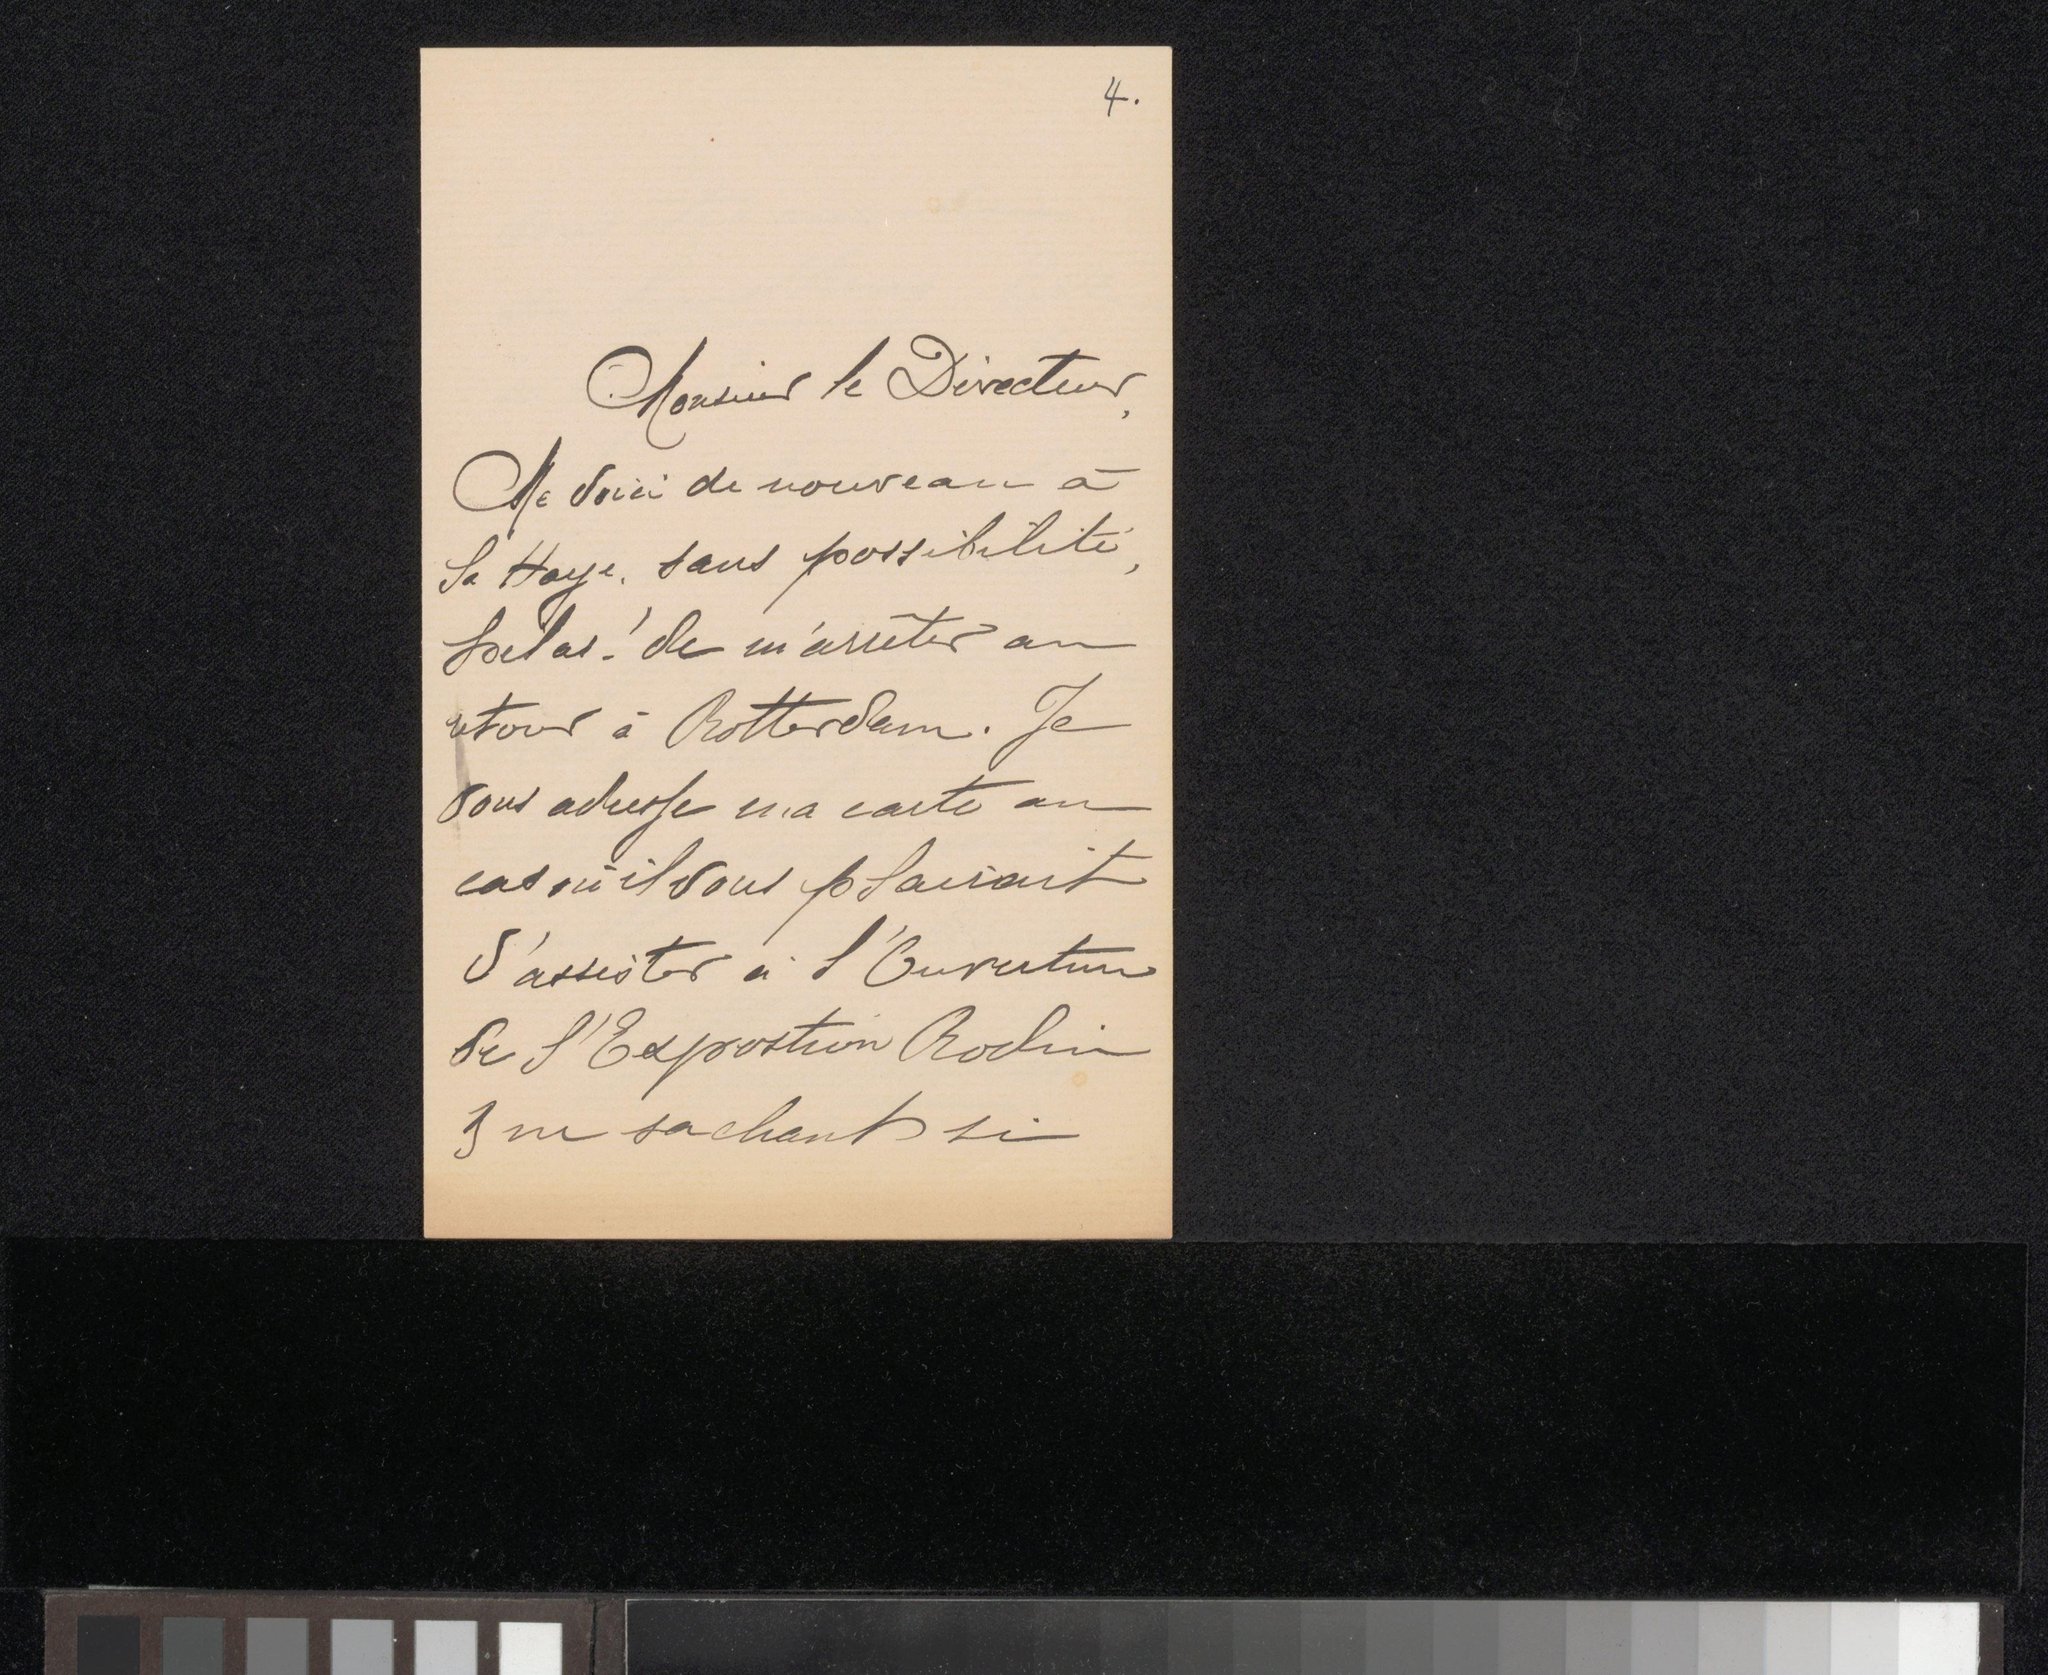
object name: letter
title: Brief aan Pieter Haverkorn van Rijsewijk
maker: judith cladel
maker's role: auteur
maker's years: 1873-1958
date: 1899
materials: ink, paper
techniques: pen, writing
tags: print maker, draughtsman, auguste rodin, pieter haverkorn van rijsewijk, exhibition ~ art, the hague, rotterdam